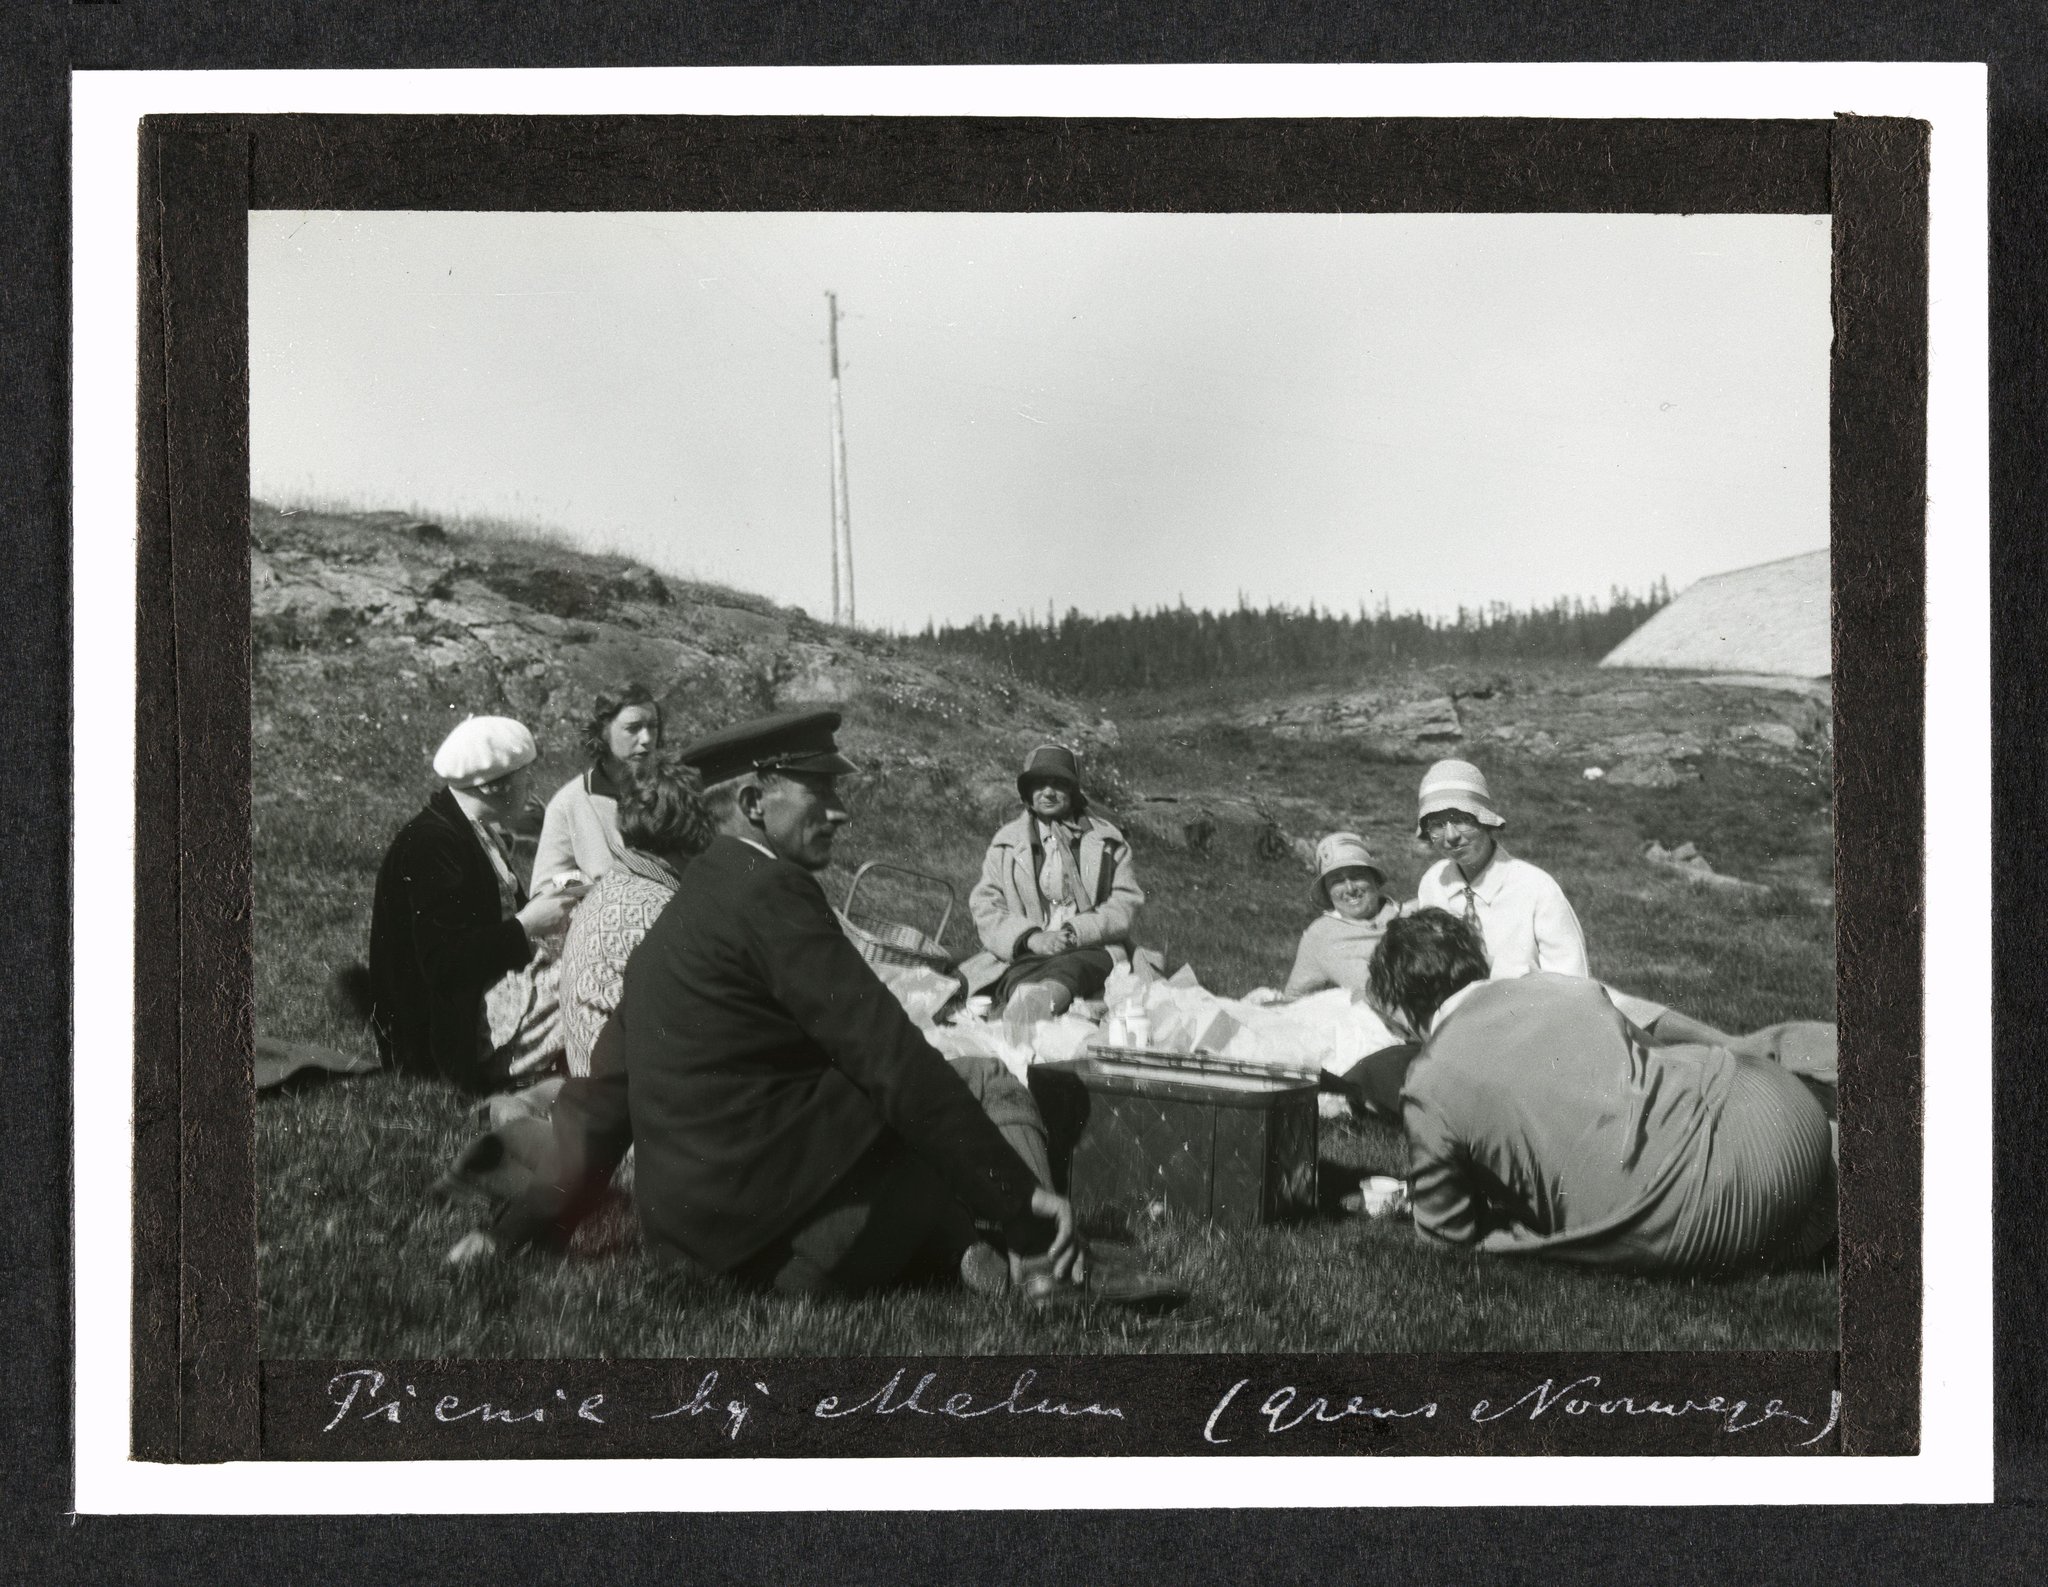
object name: glasdia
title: Piemie bij Melum (grens Noorwegen)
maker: Anonymous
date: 1907-1935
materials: glass, ink, paper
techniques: slide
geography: mælum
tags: meadow, pasture, sitting on the ground